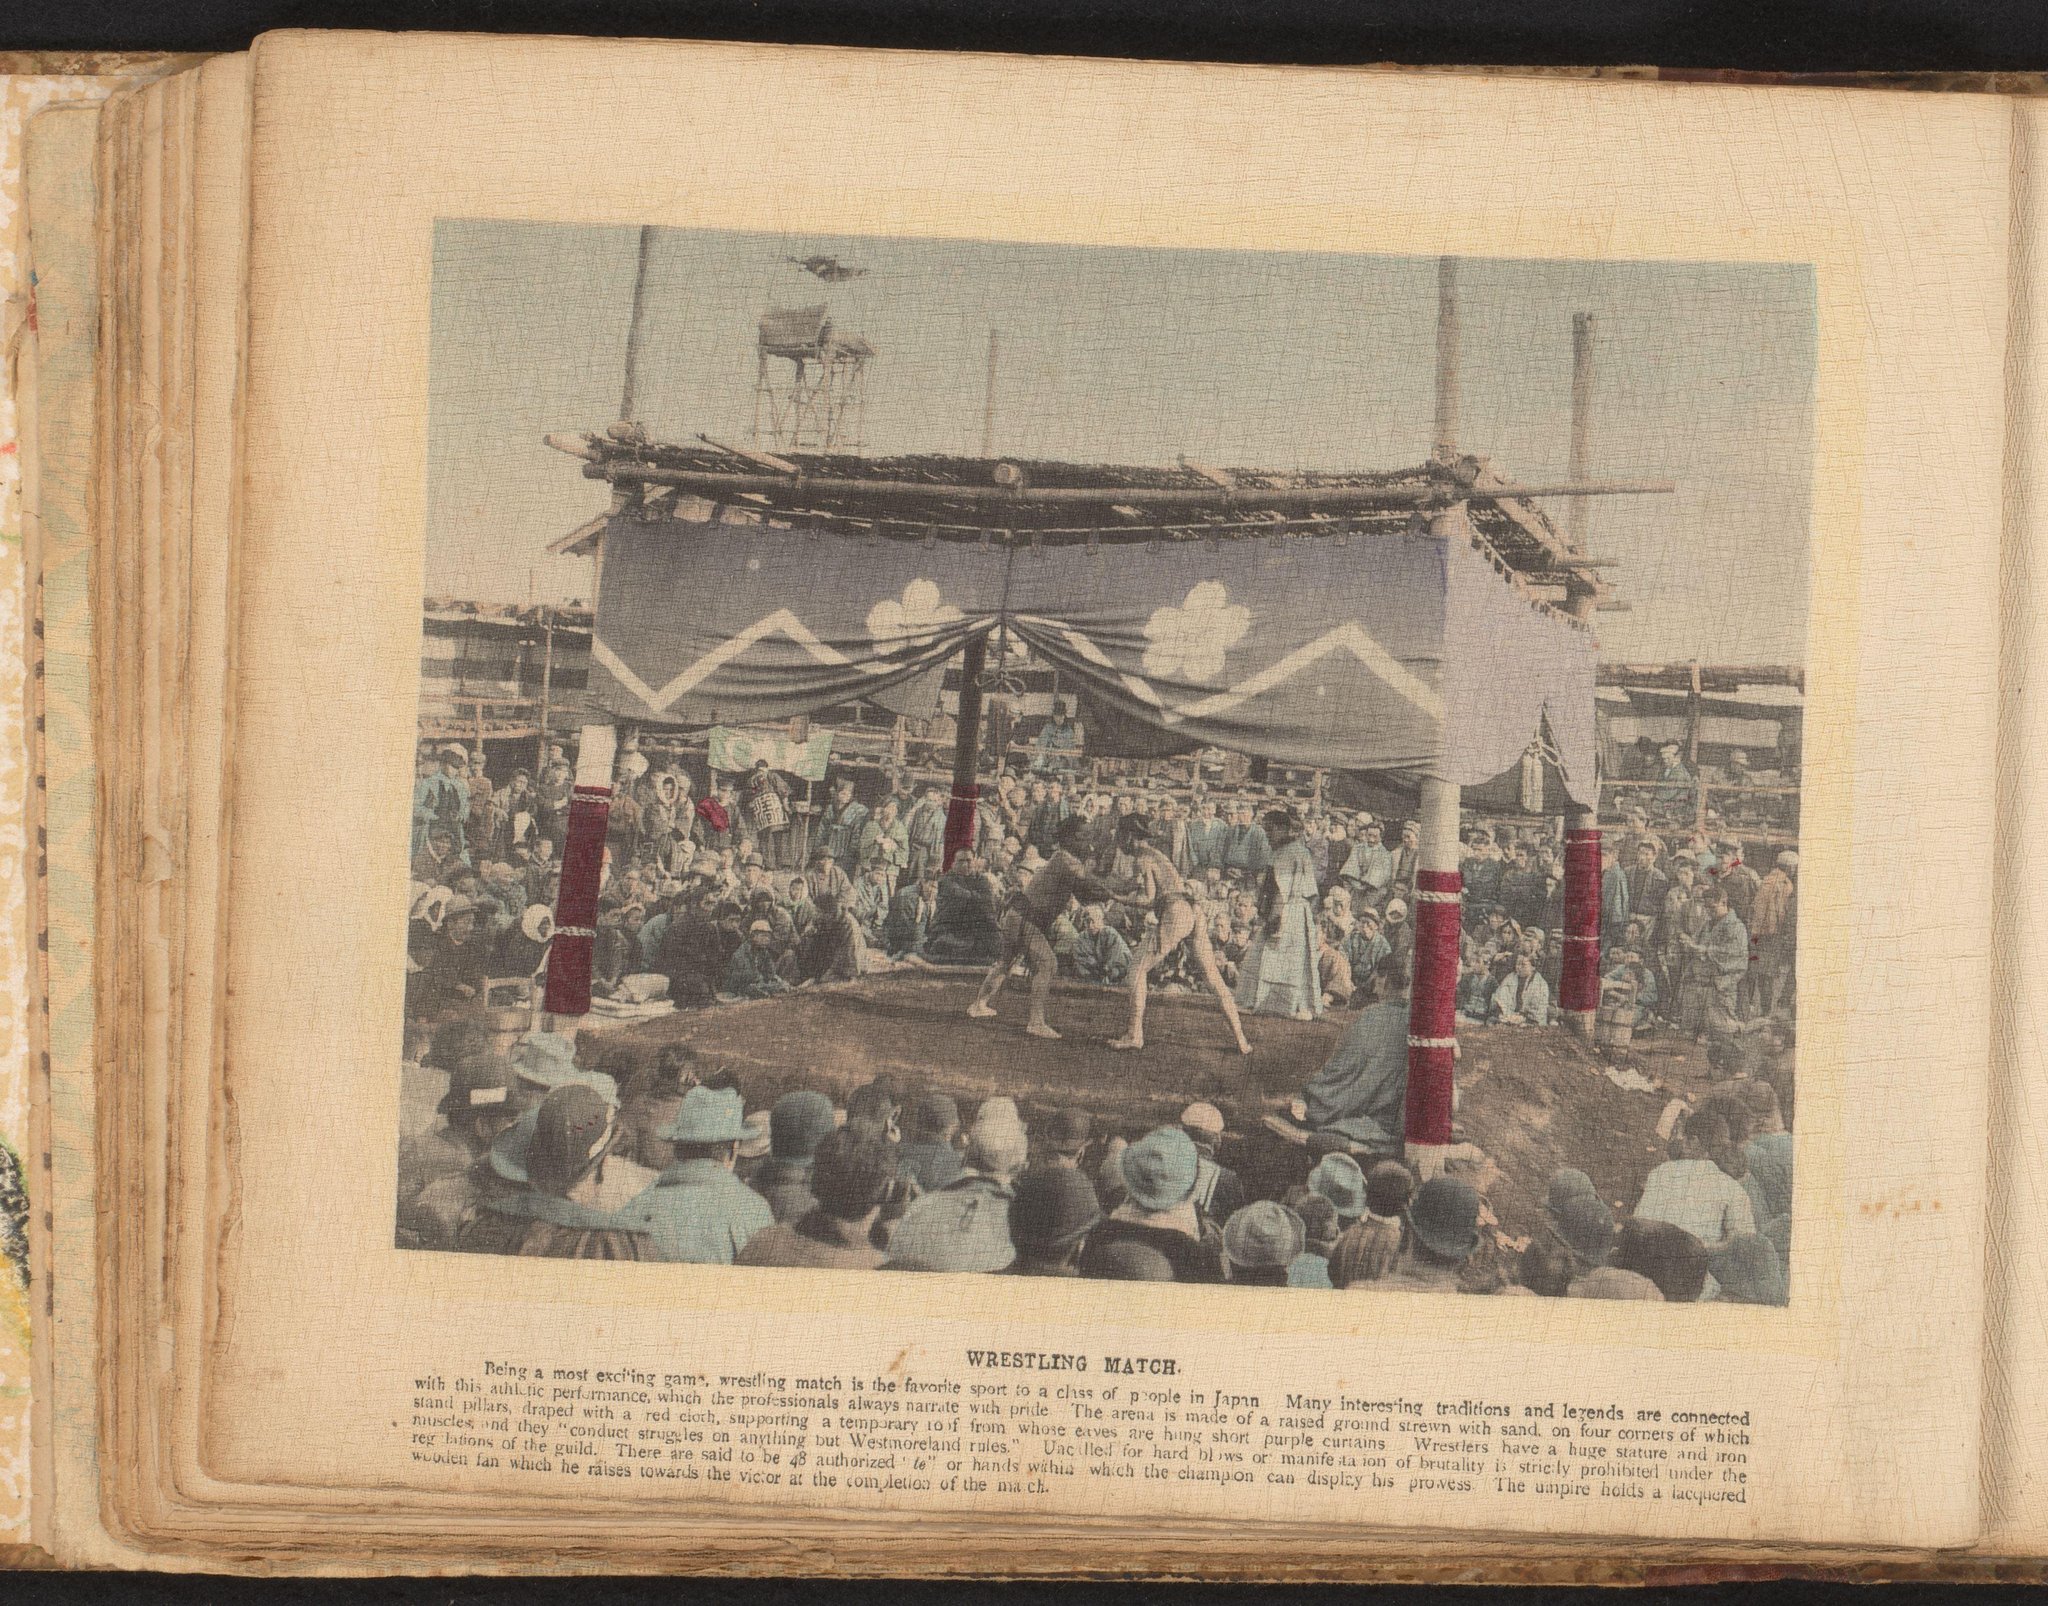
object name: page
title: Gezicht op een worstelwedstrijd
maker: Anonymous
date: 1891-1896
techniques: collotype process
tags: wrestling (sport), japan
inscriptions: inscription: ‘Being a most exciting game, wrestling match is the favorite sport to a class of people in Japan. [...]’